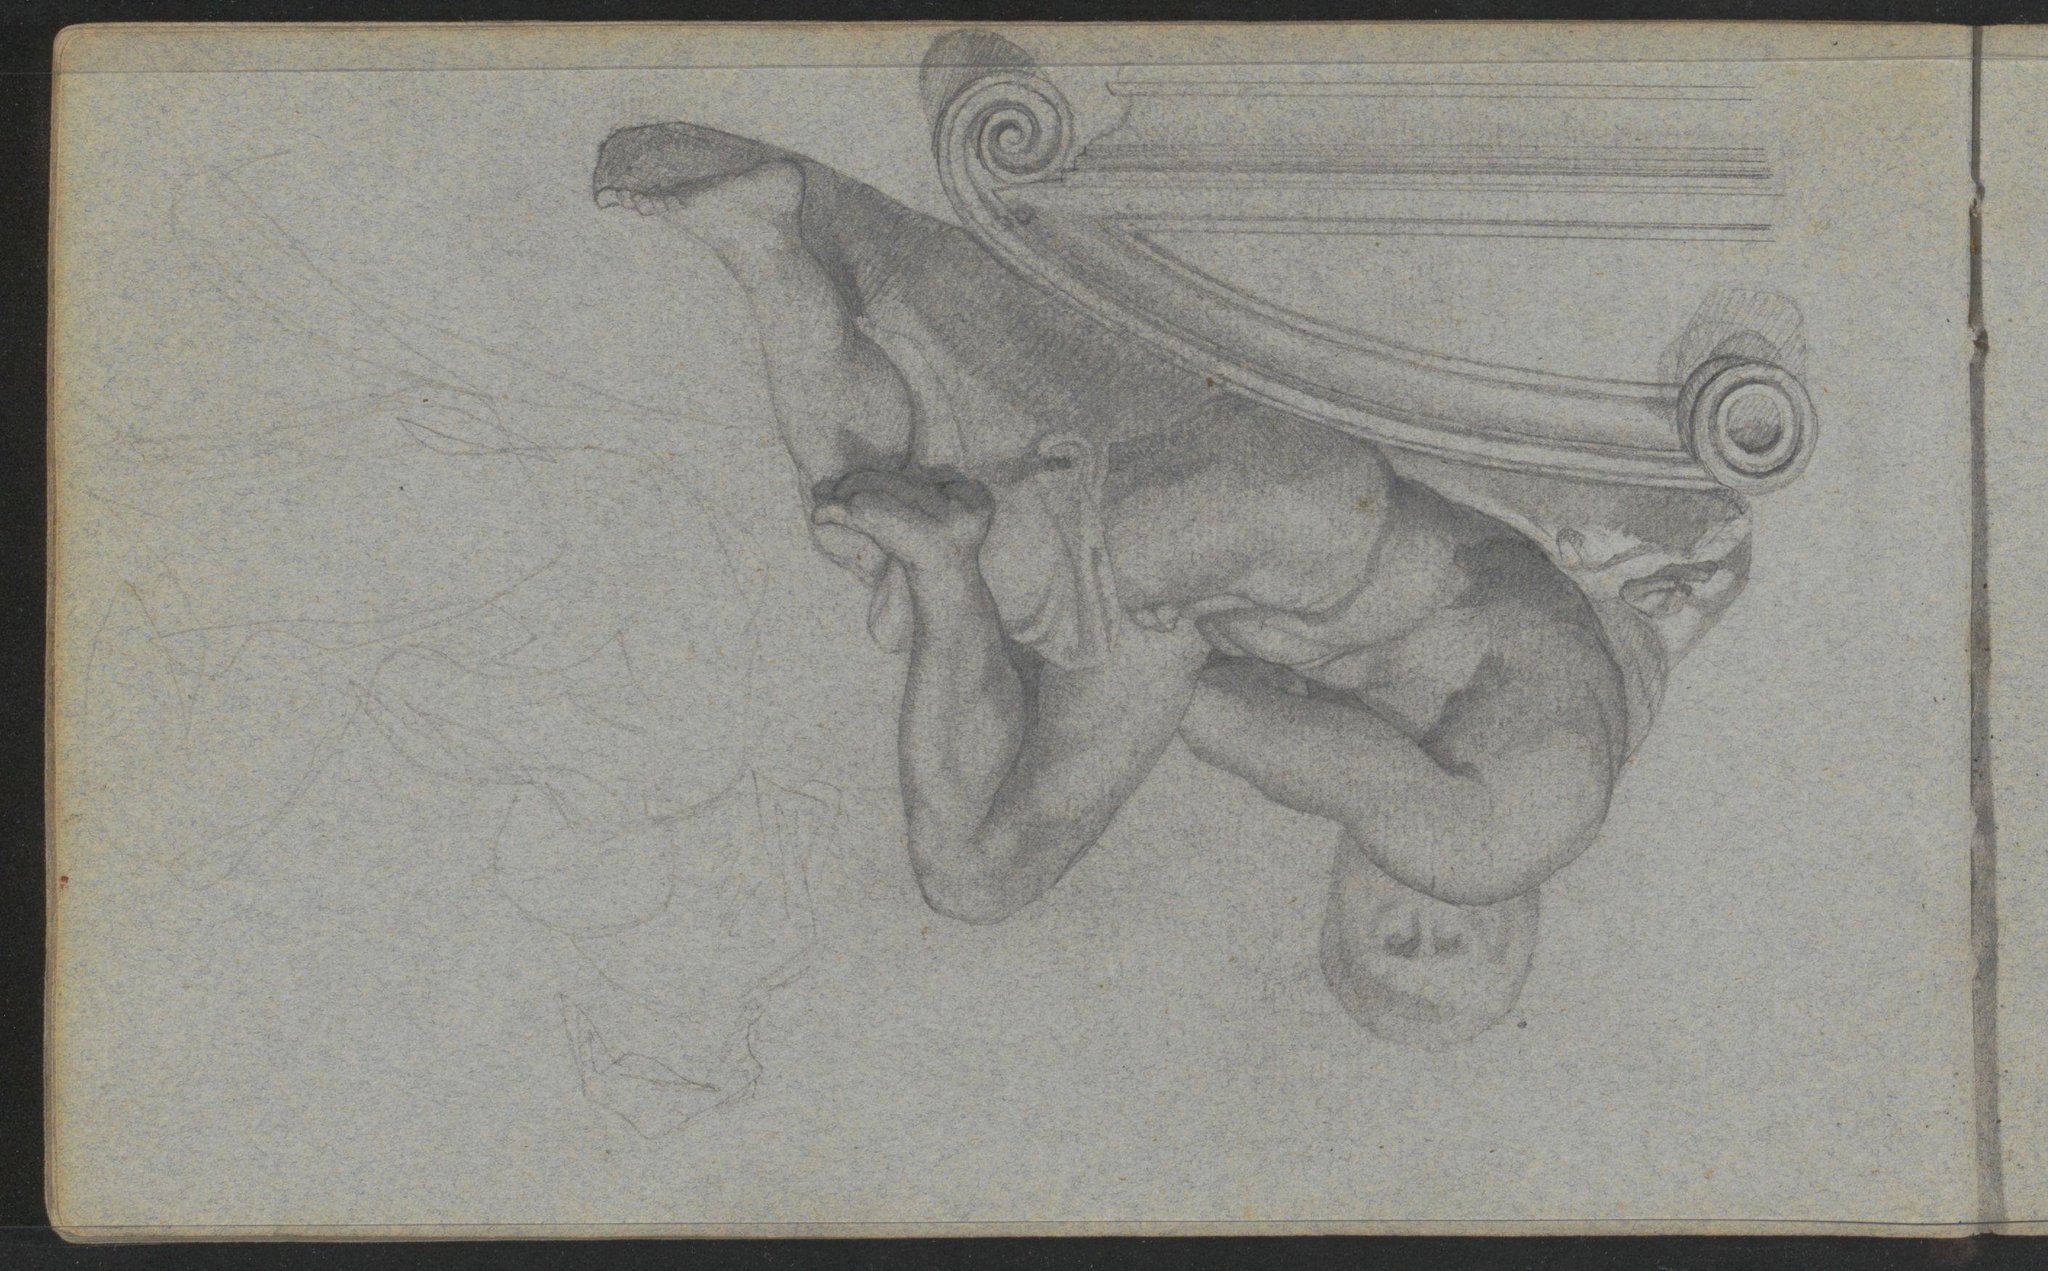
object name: sketchbook leaf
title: Naakte man liggend op een kroonlijst met rolwerk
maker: matthijs maris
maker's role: draughtsman, painter, print maker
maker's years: 1839-1917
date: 1849-1917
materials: paper, pencil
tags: ribbon, scroll, banderole ~ ornament, lying figure, man (showing himself) undressed, quasi-nude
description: Vermoedelijk een kopie naar een Italiaanse meester.